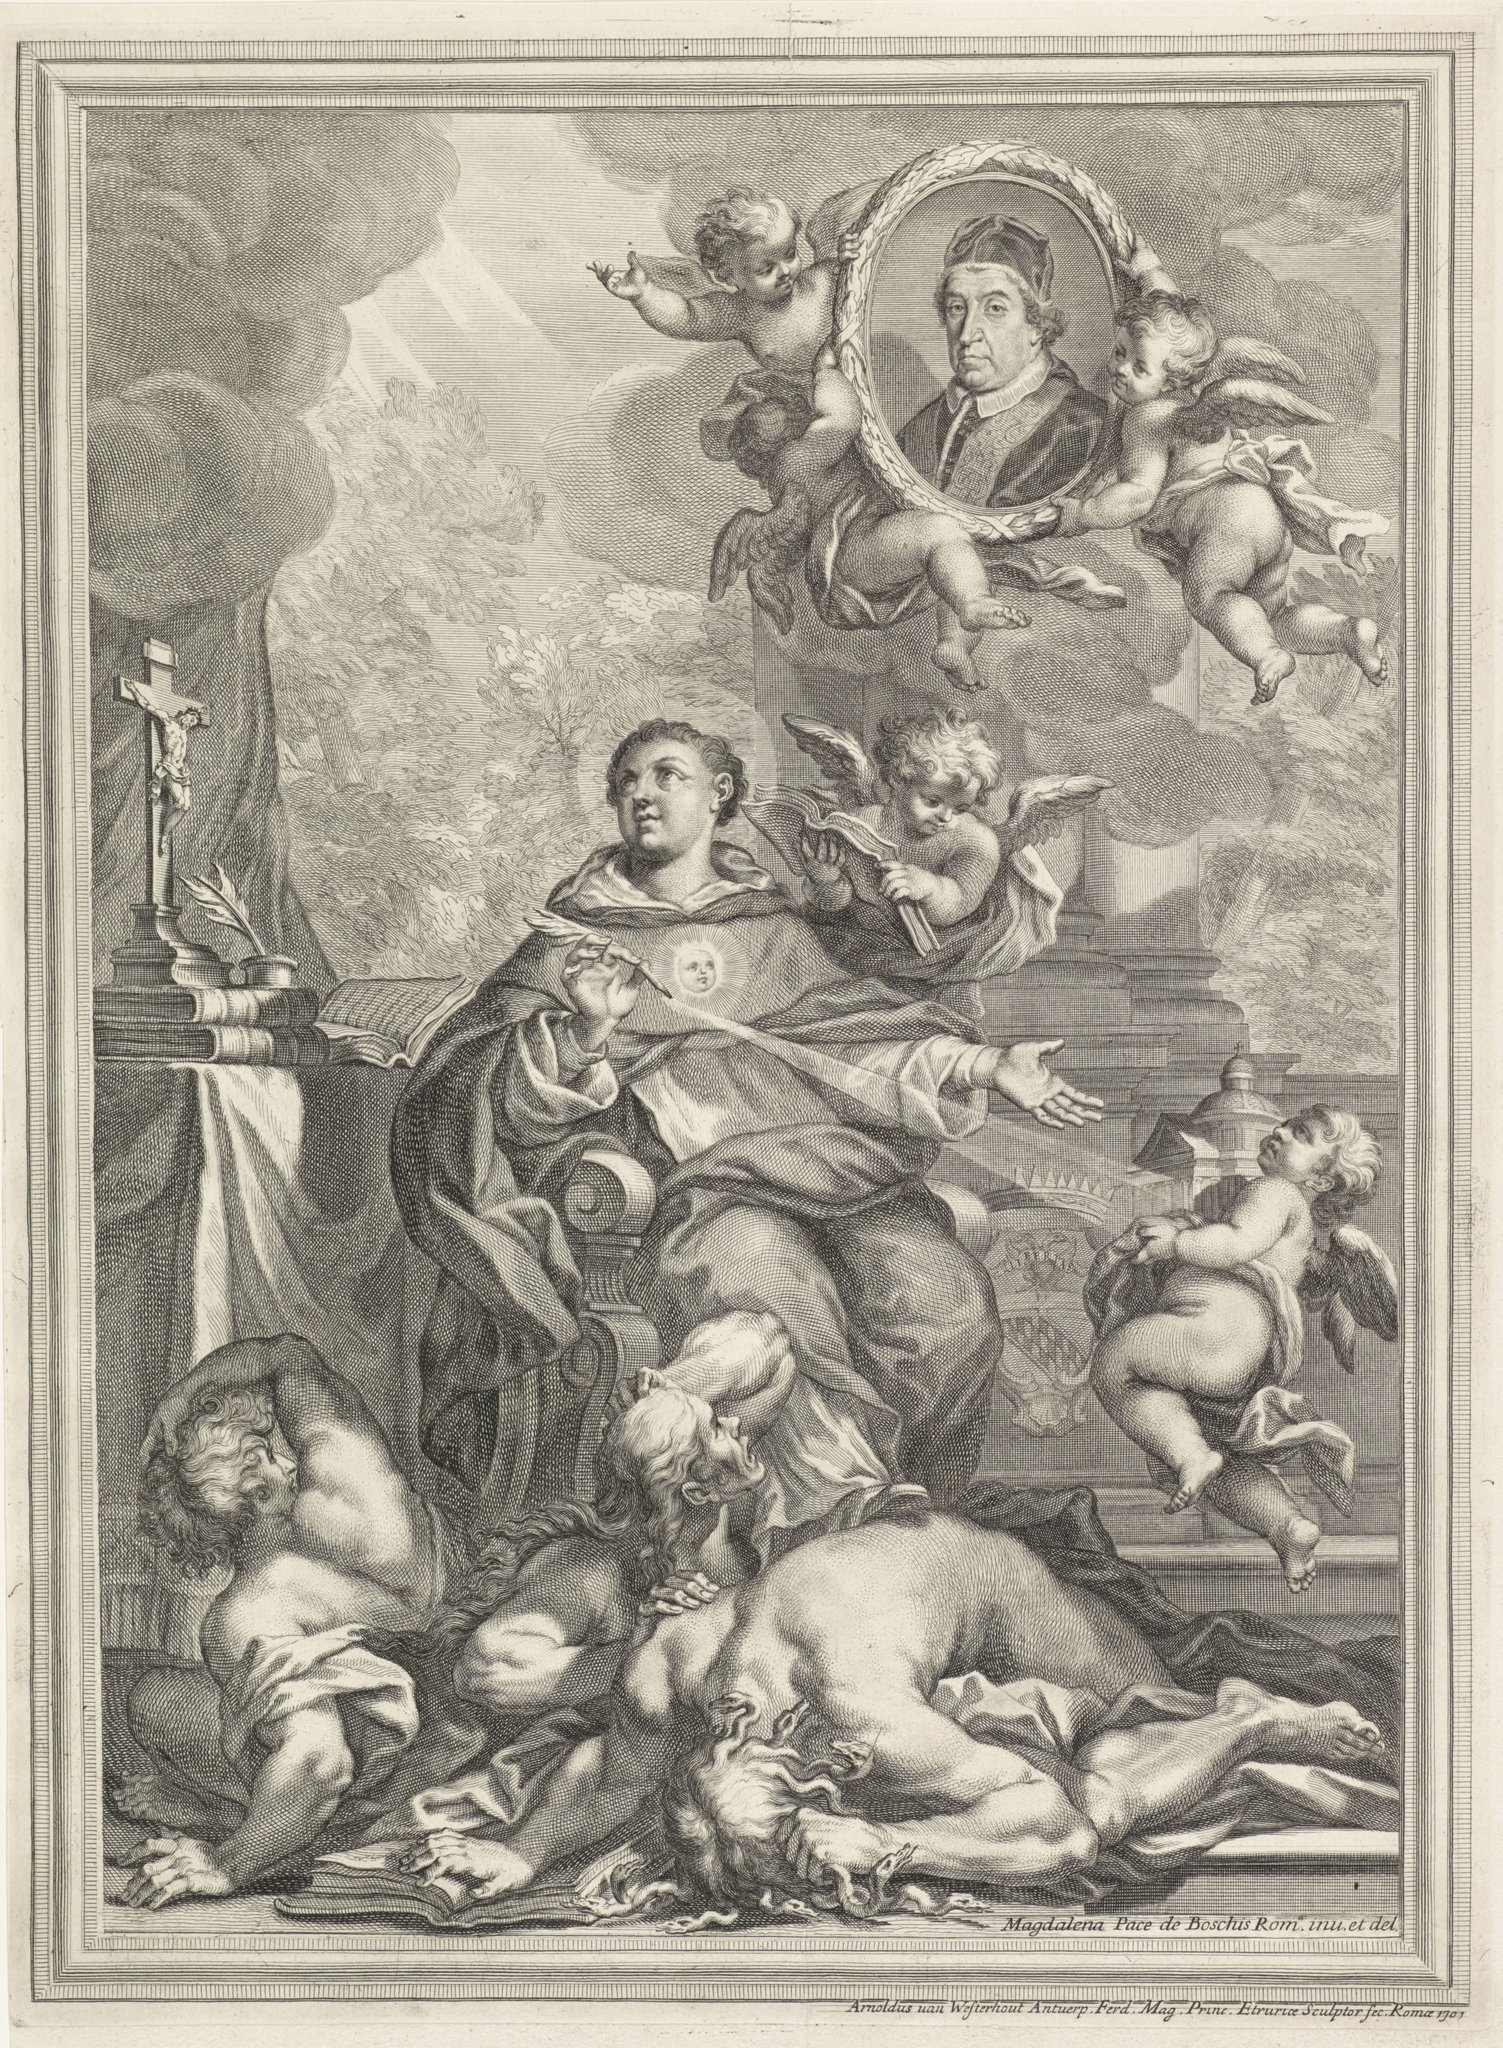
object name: print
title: H. Thomas van Aquino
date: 1680-1725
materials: paper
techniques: engraving, etching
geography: rome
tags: thomas van aquino, rome, clergyman, clemens xi, crucifix ~ personal devotion, writing accessories, cheat, deceit; 'fraude', 'inganno' (ripa), the dominican theologian, 'angelic doctor' thomas of aquino; possible attributes: book, (chain with) sun, dove, girdle of chastity, lily, model of church, monstrance (or chalice), mitre (under feet), star (on breast), heresy; 'heresia' (ripa), armorial bearing, heraldry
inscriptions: collector's mark: Lugt 2228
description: De heilige Thomas van Aquino zit naast zijn schrijftafel. Op de tafel een stapel boeken en een crucifix. In zijn hand houdt hij een schrijfveer. Een engel komt aanvliegen met het model van een kerk, dat wordt beschenen door een lichtstraal uit zijn veer. Achter hem een engel met een opengeslagen boek. Aan zijn voeten liggen drie figuren die Bedrog en Ketterij symboliseren. In de lucht vliegen drie engelen met het portret van paus Clemens XI.